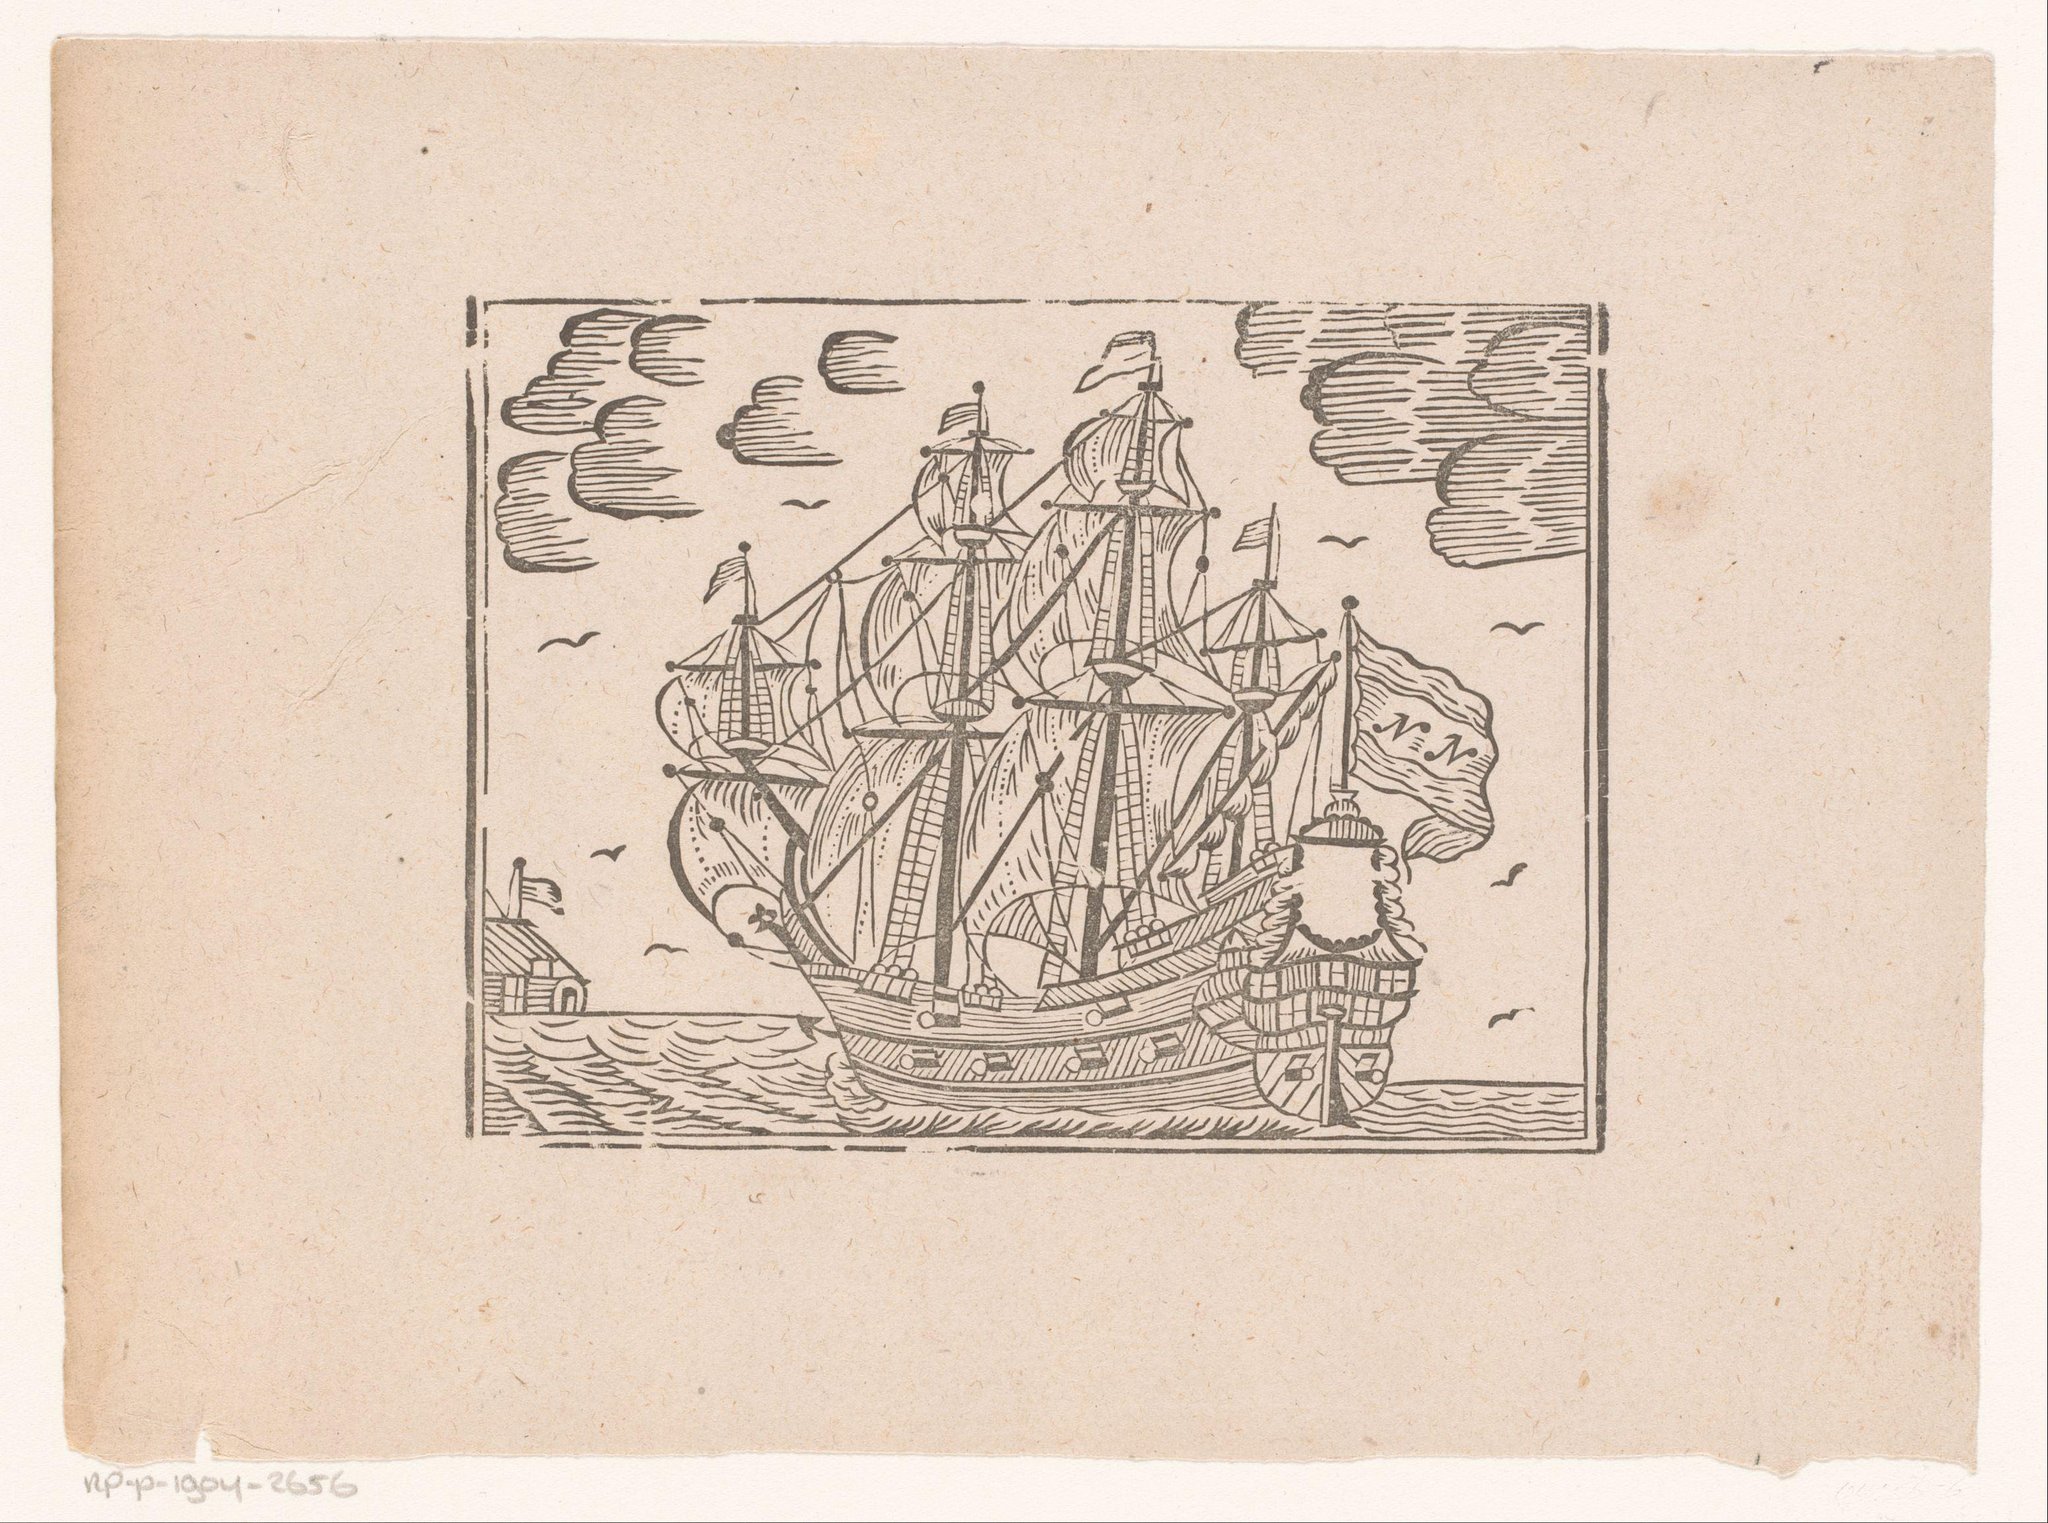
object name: print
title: Schip op het water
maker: Anonymous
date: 1700-1799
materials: paper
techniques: woodcut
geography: netherlands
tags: ships (in general)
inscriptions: collector's mark: Lugt 2228